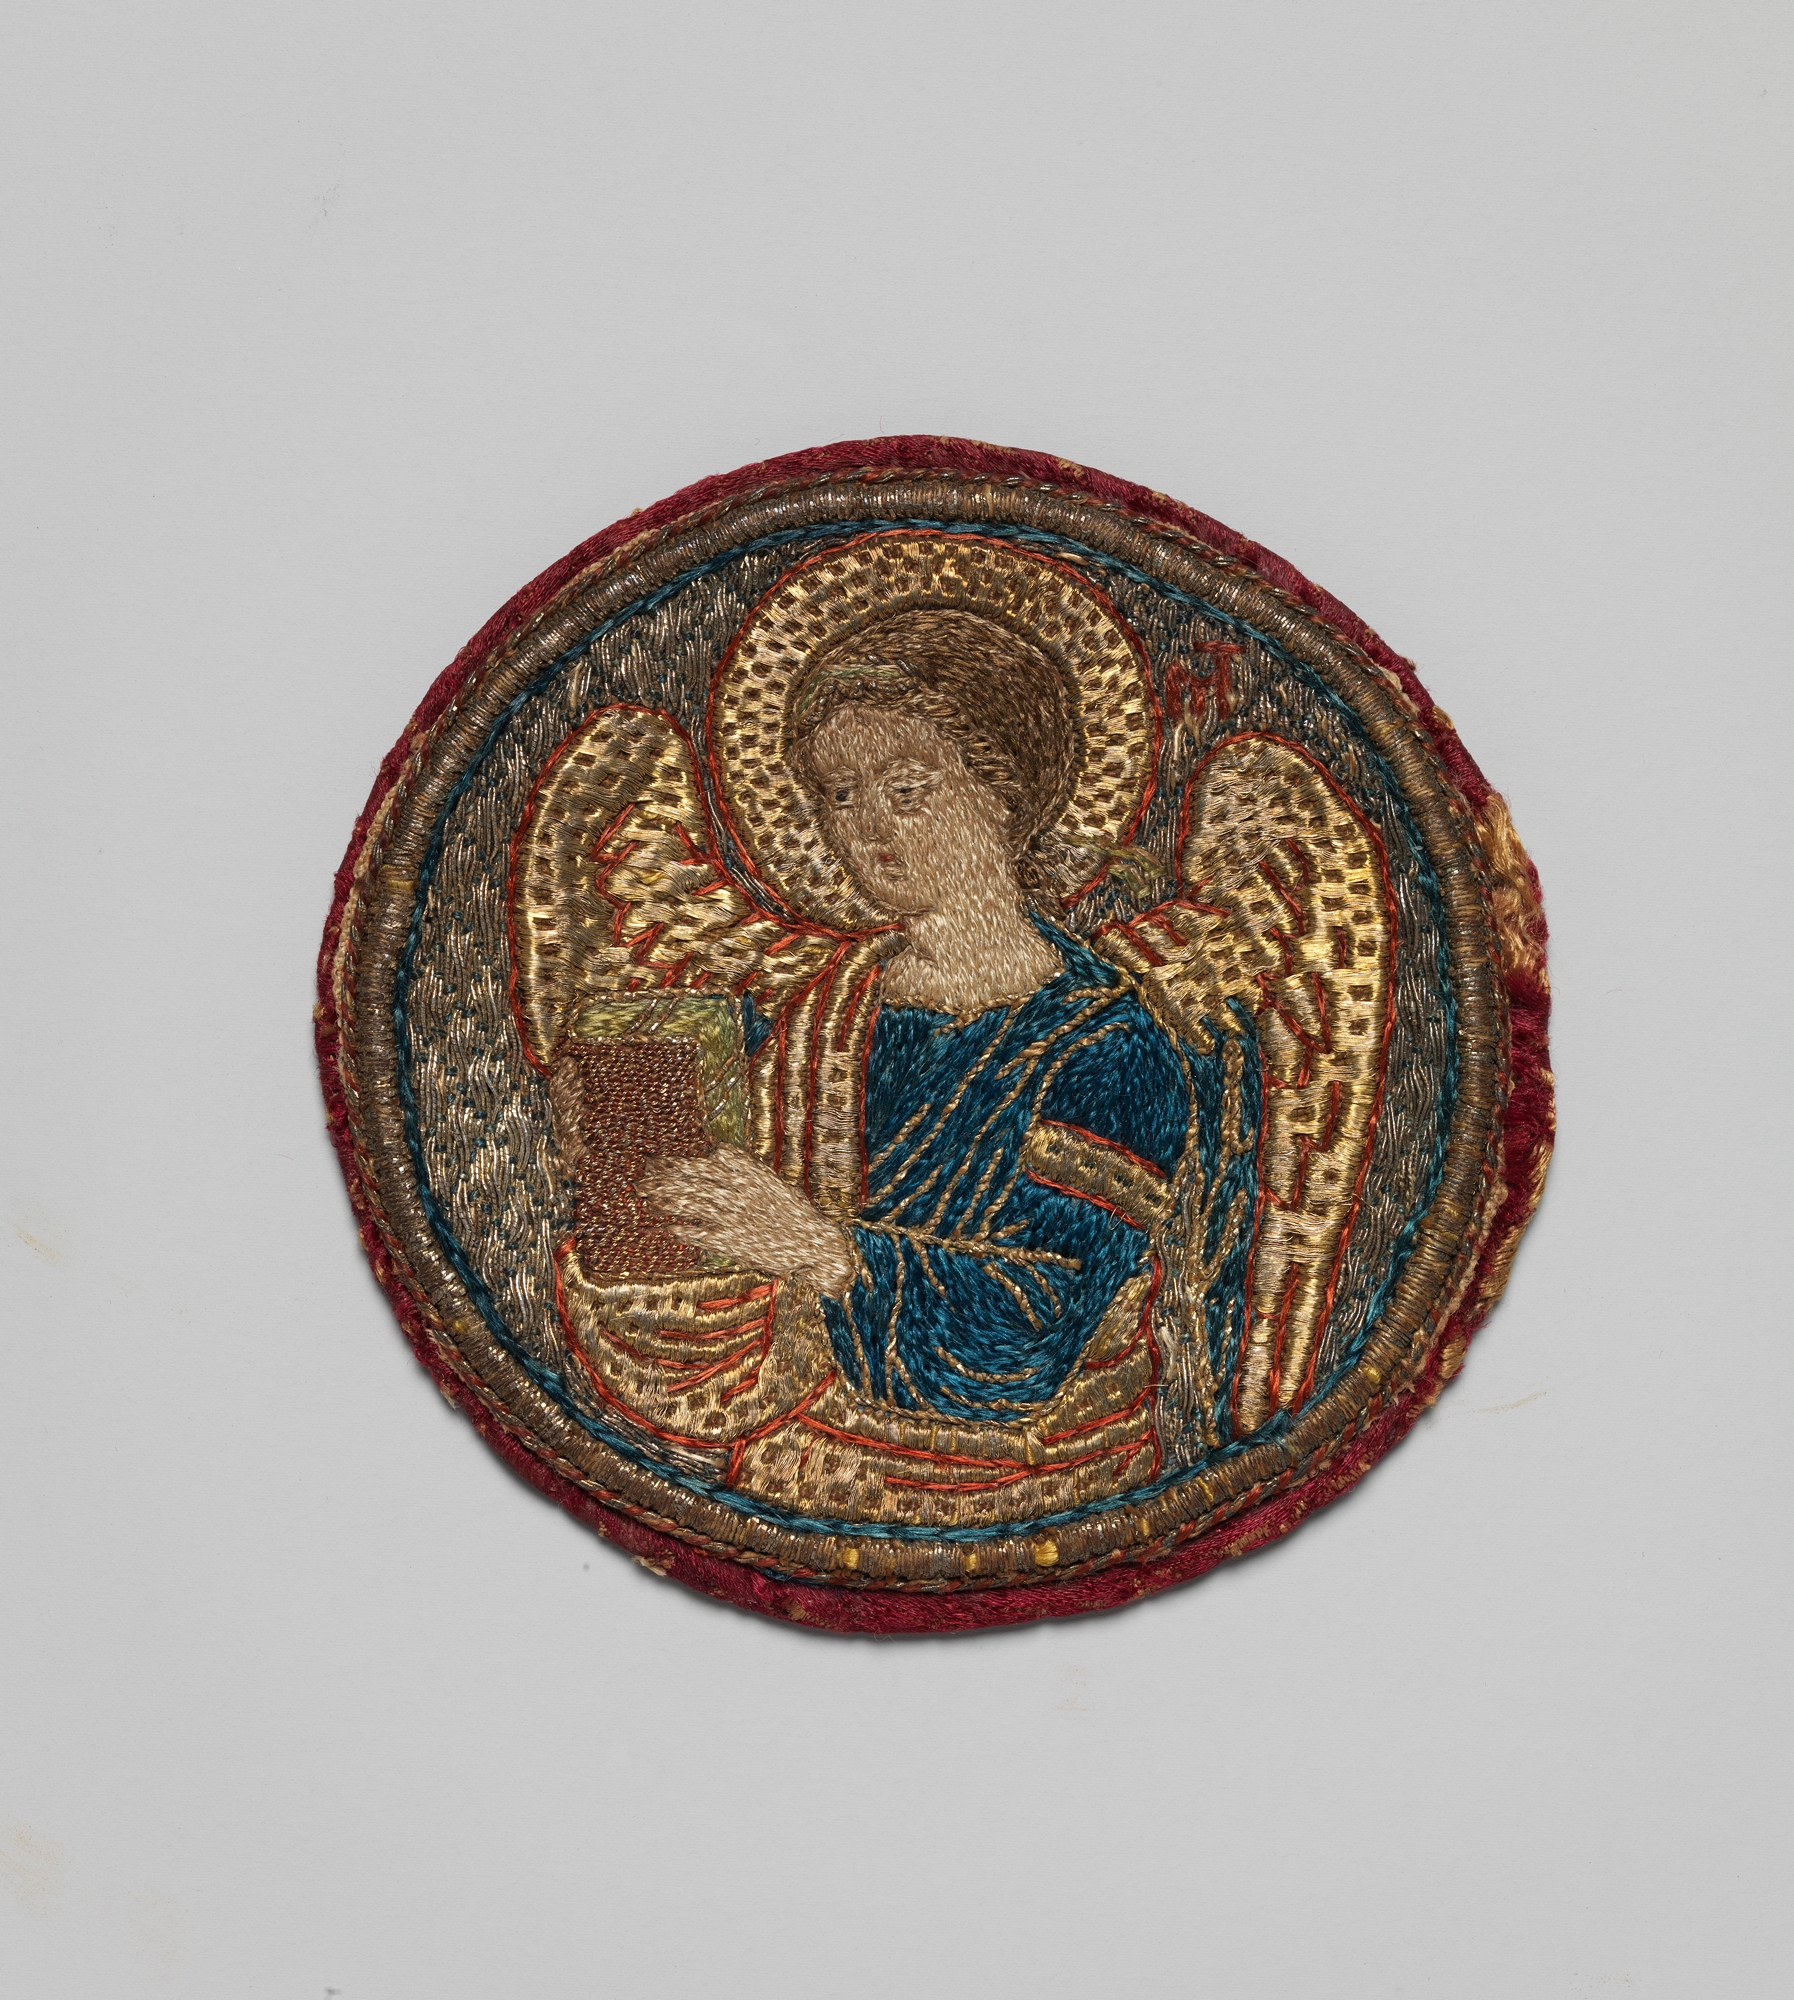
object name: embroidered medallion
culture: byzantine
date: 1401-1600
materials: linen, metal thread, silk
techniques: embroidery, weave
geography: greece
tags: angels